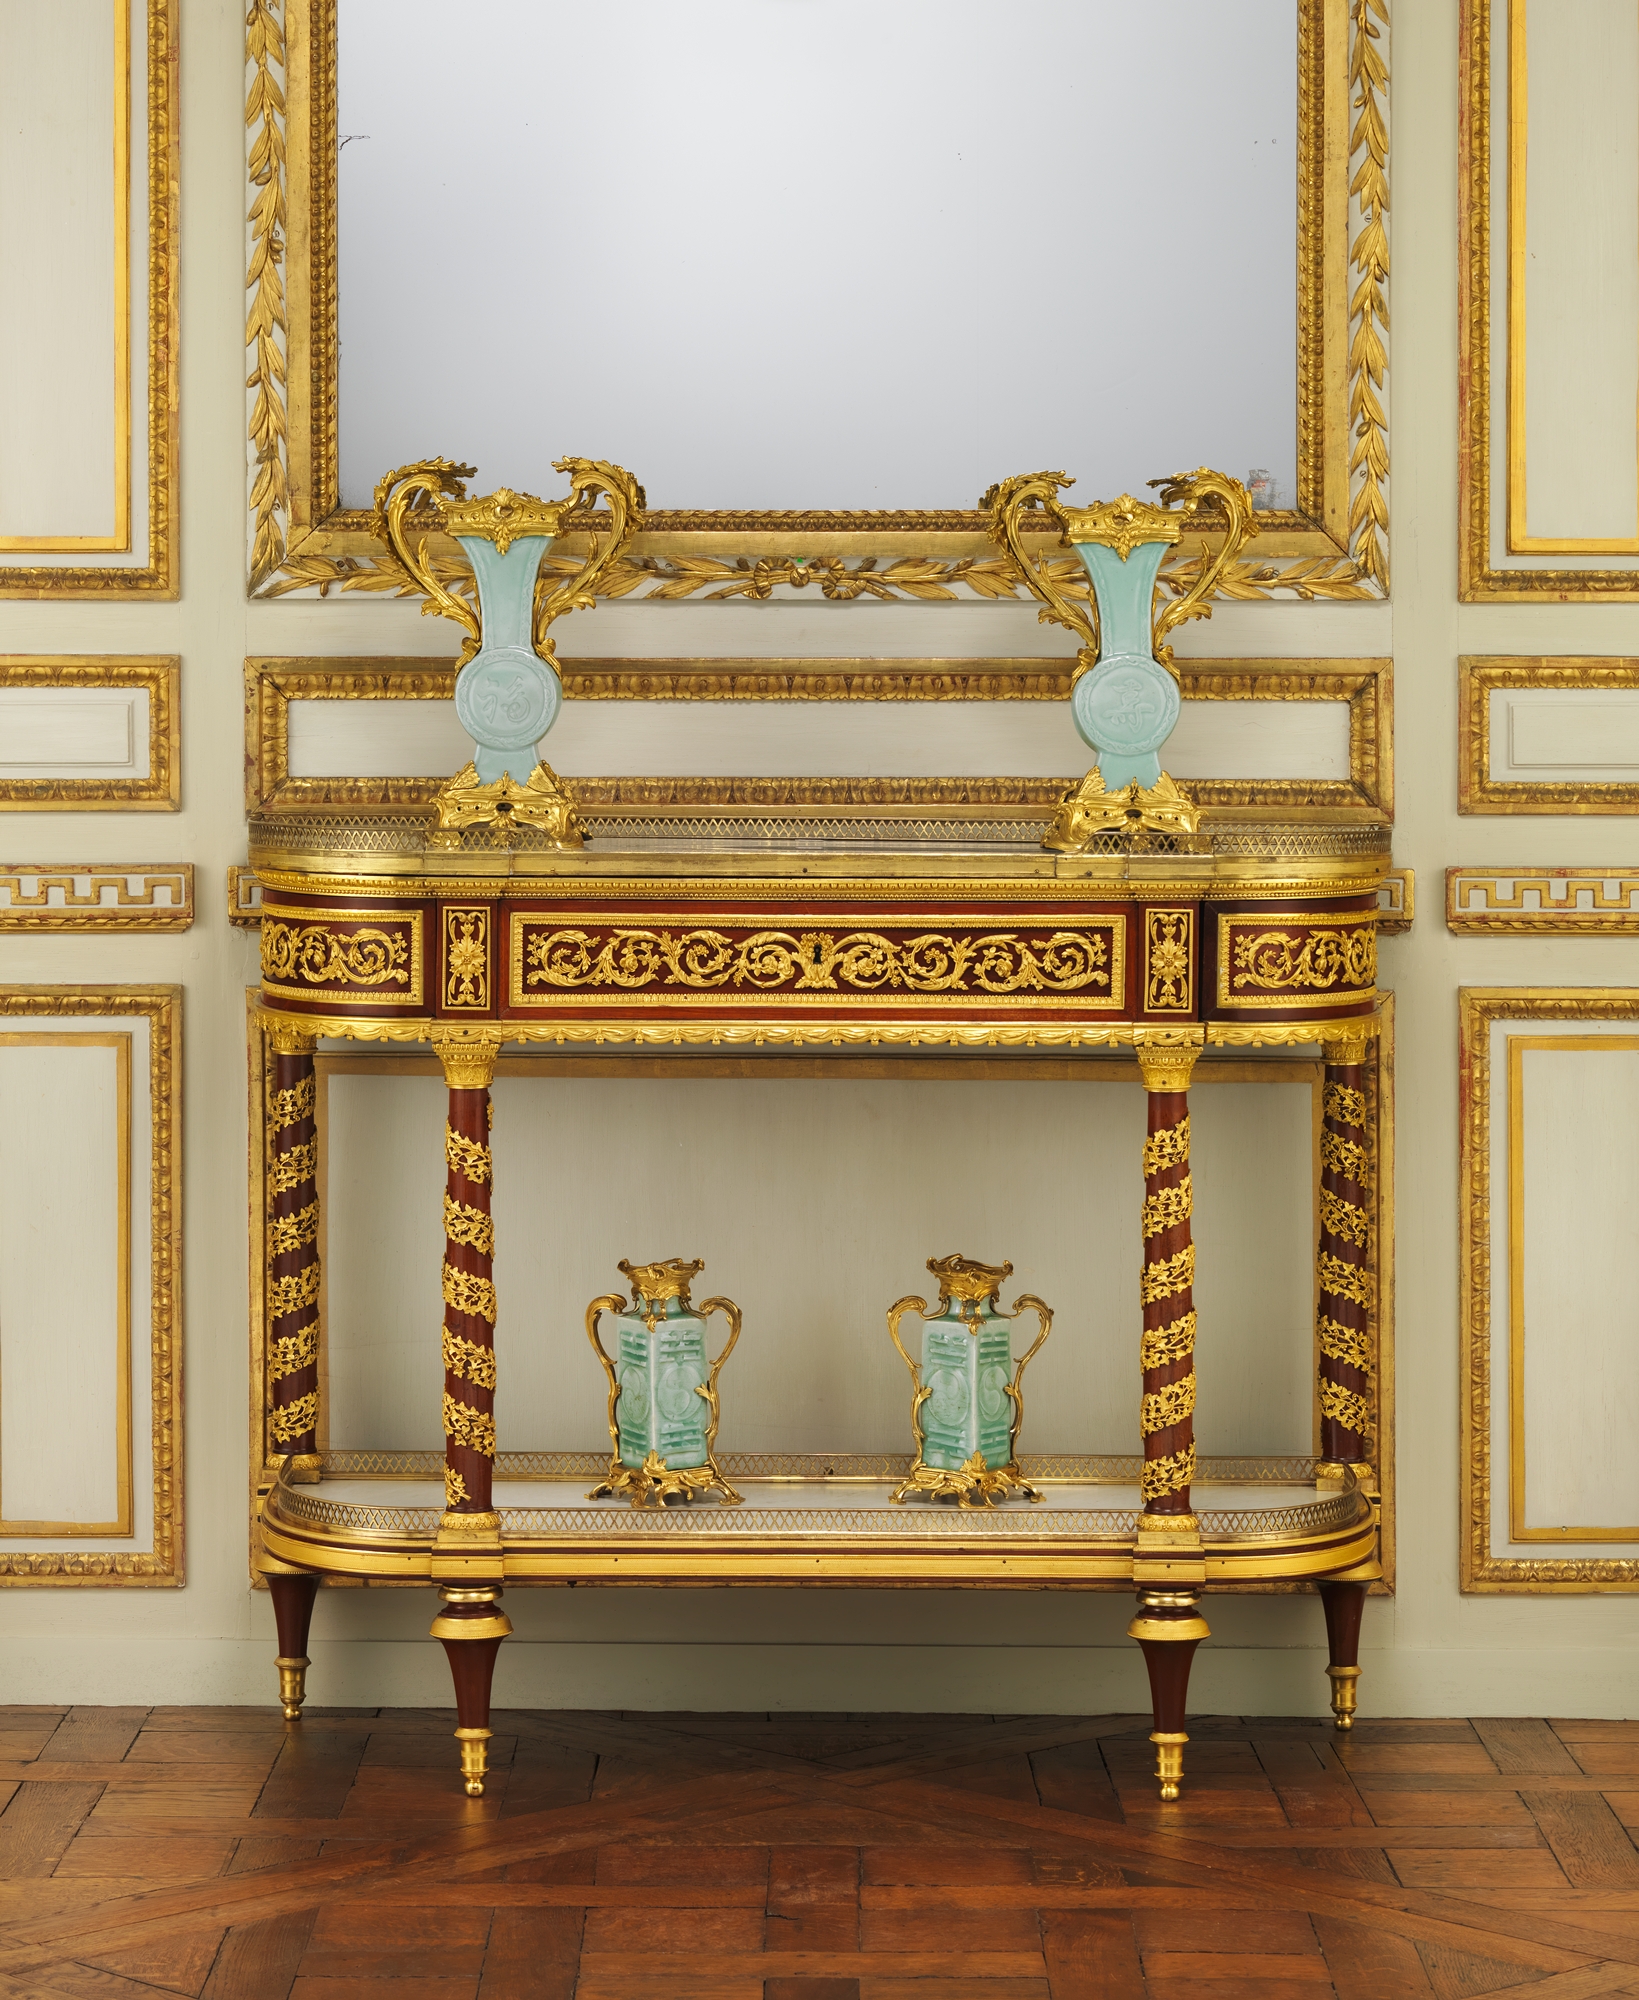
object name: side table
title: Side table (commode servante or commode desserte)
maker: jean henri riesener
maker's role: maker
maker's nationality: french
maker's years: 1734-1806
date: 1790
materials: gilt bronze, wood, marble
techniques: veneering